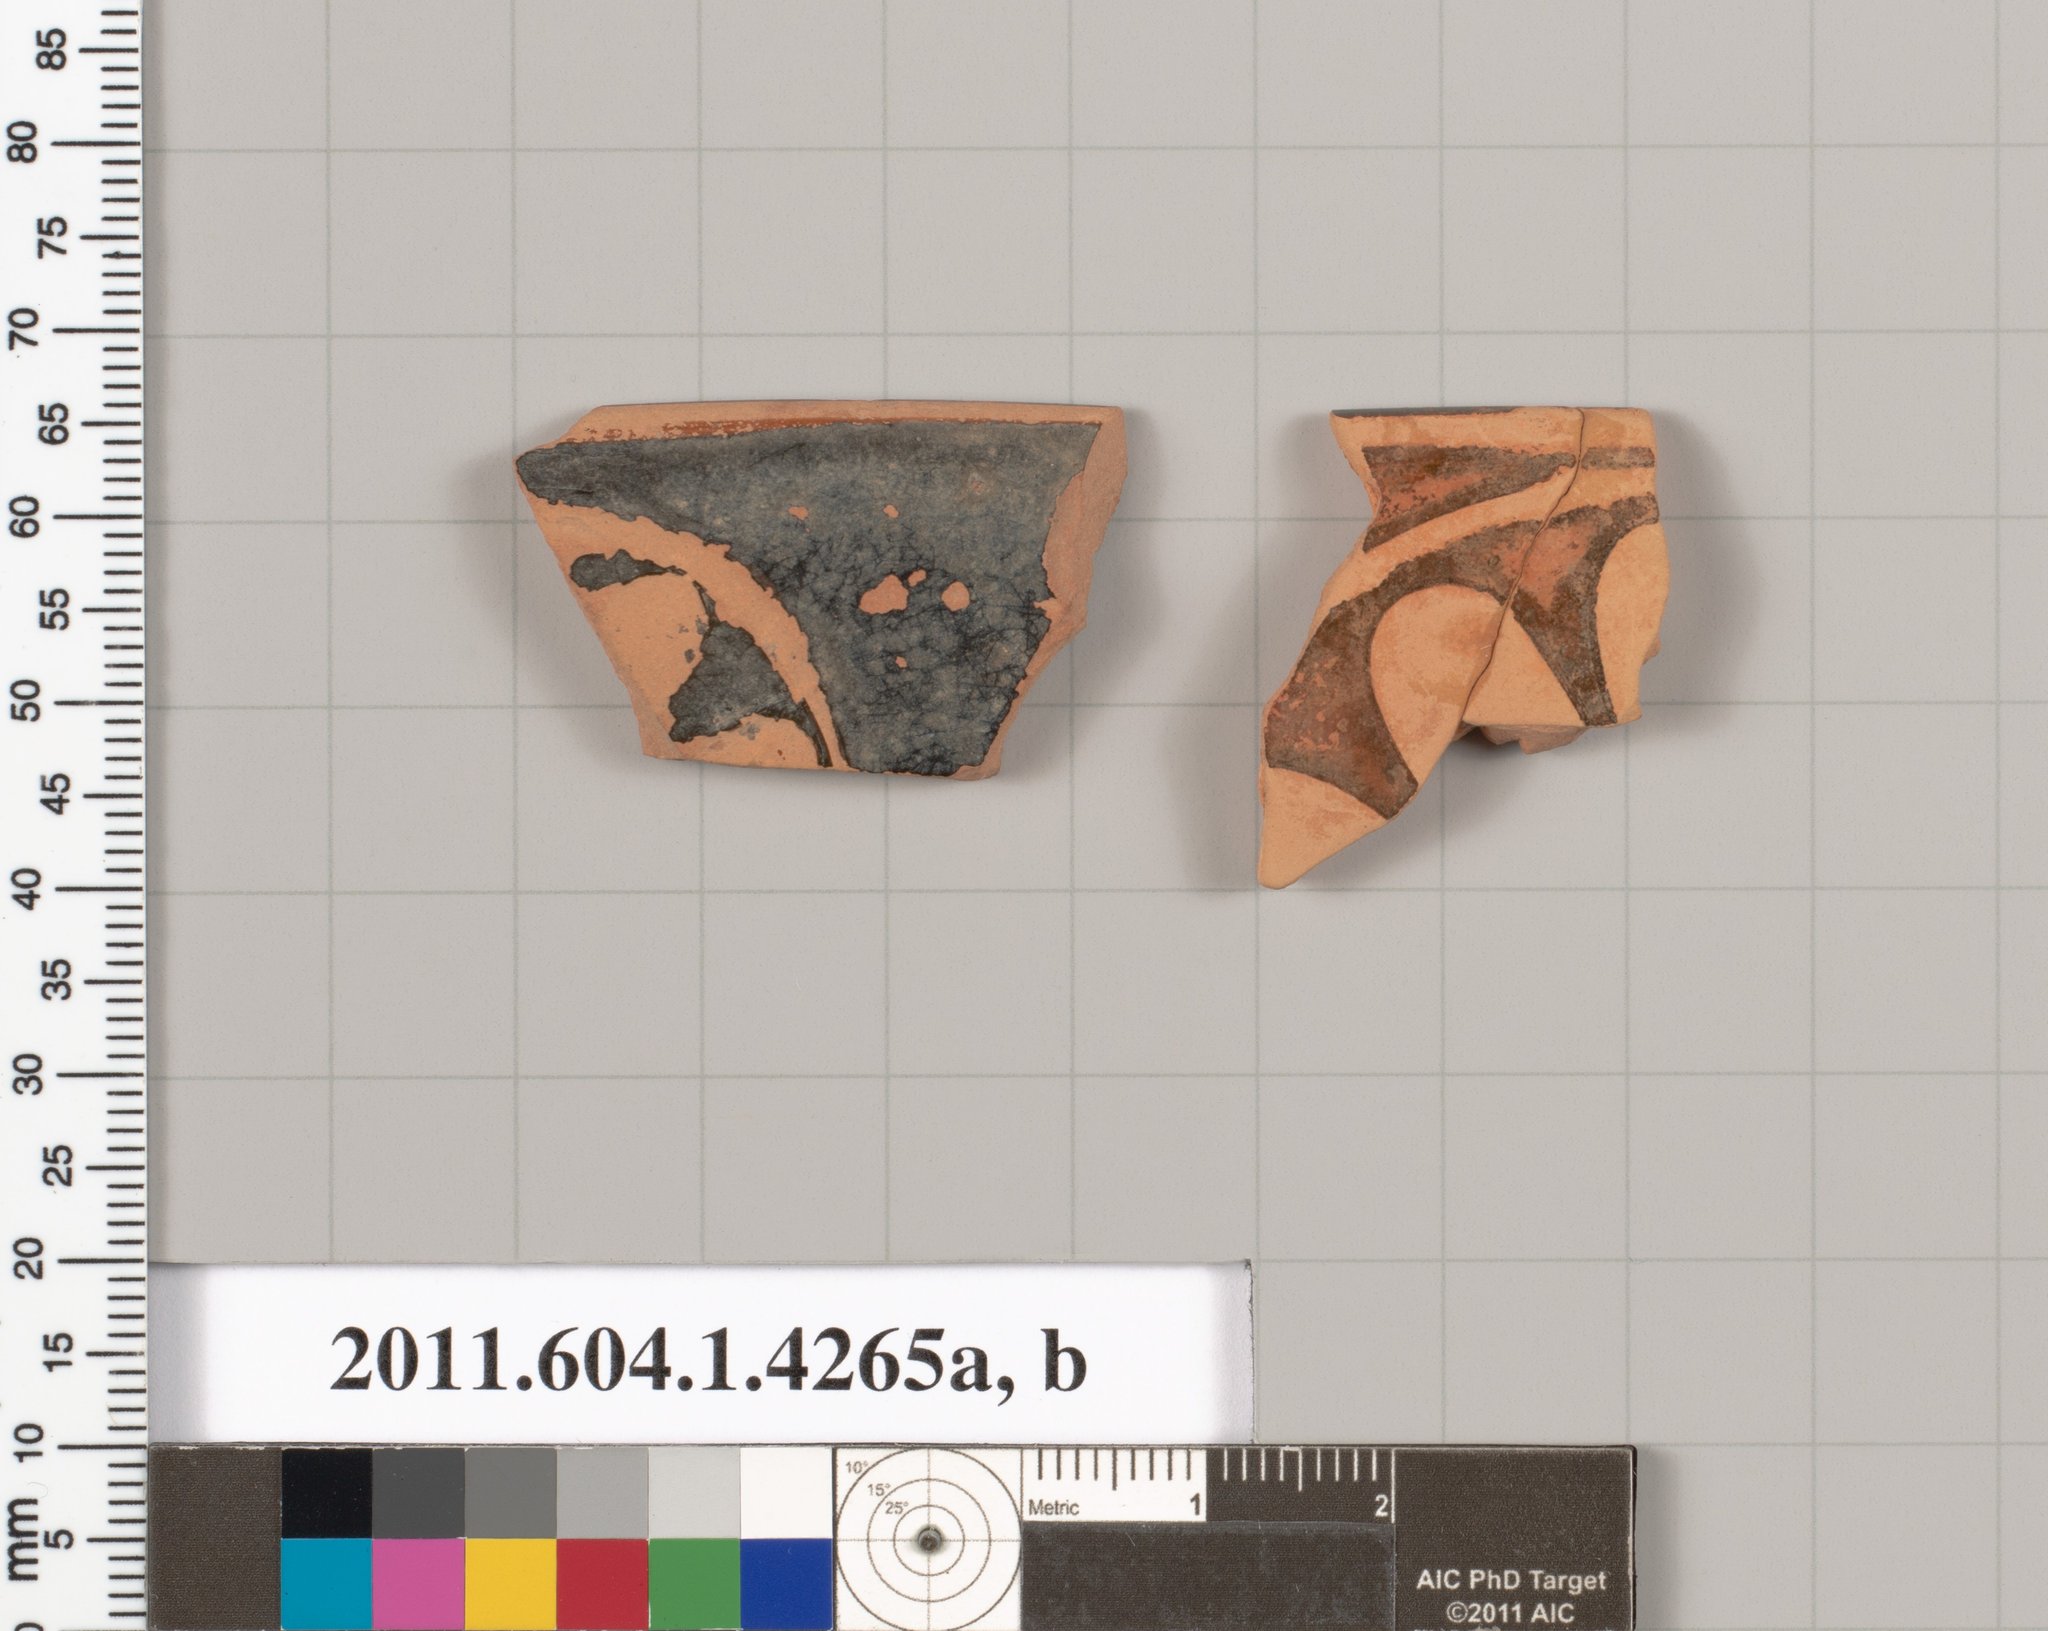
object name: kylix fragment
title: Terracotta rim fragments of kylikes (drinking cups)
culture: greek, attic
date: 520-500 BCE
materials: terracotta